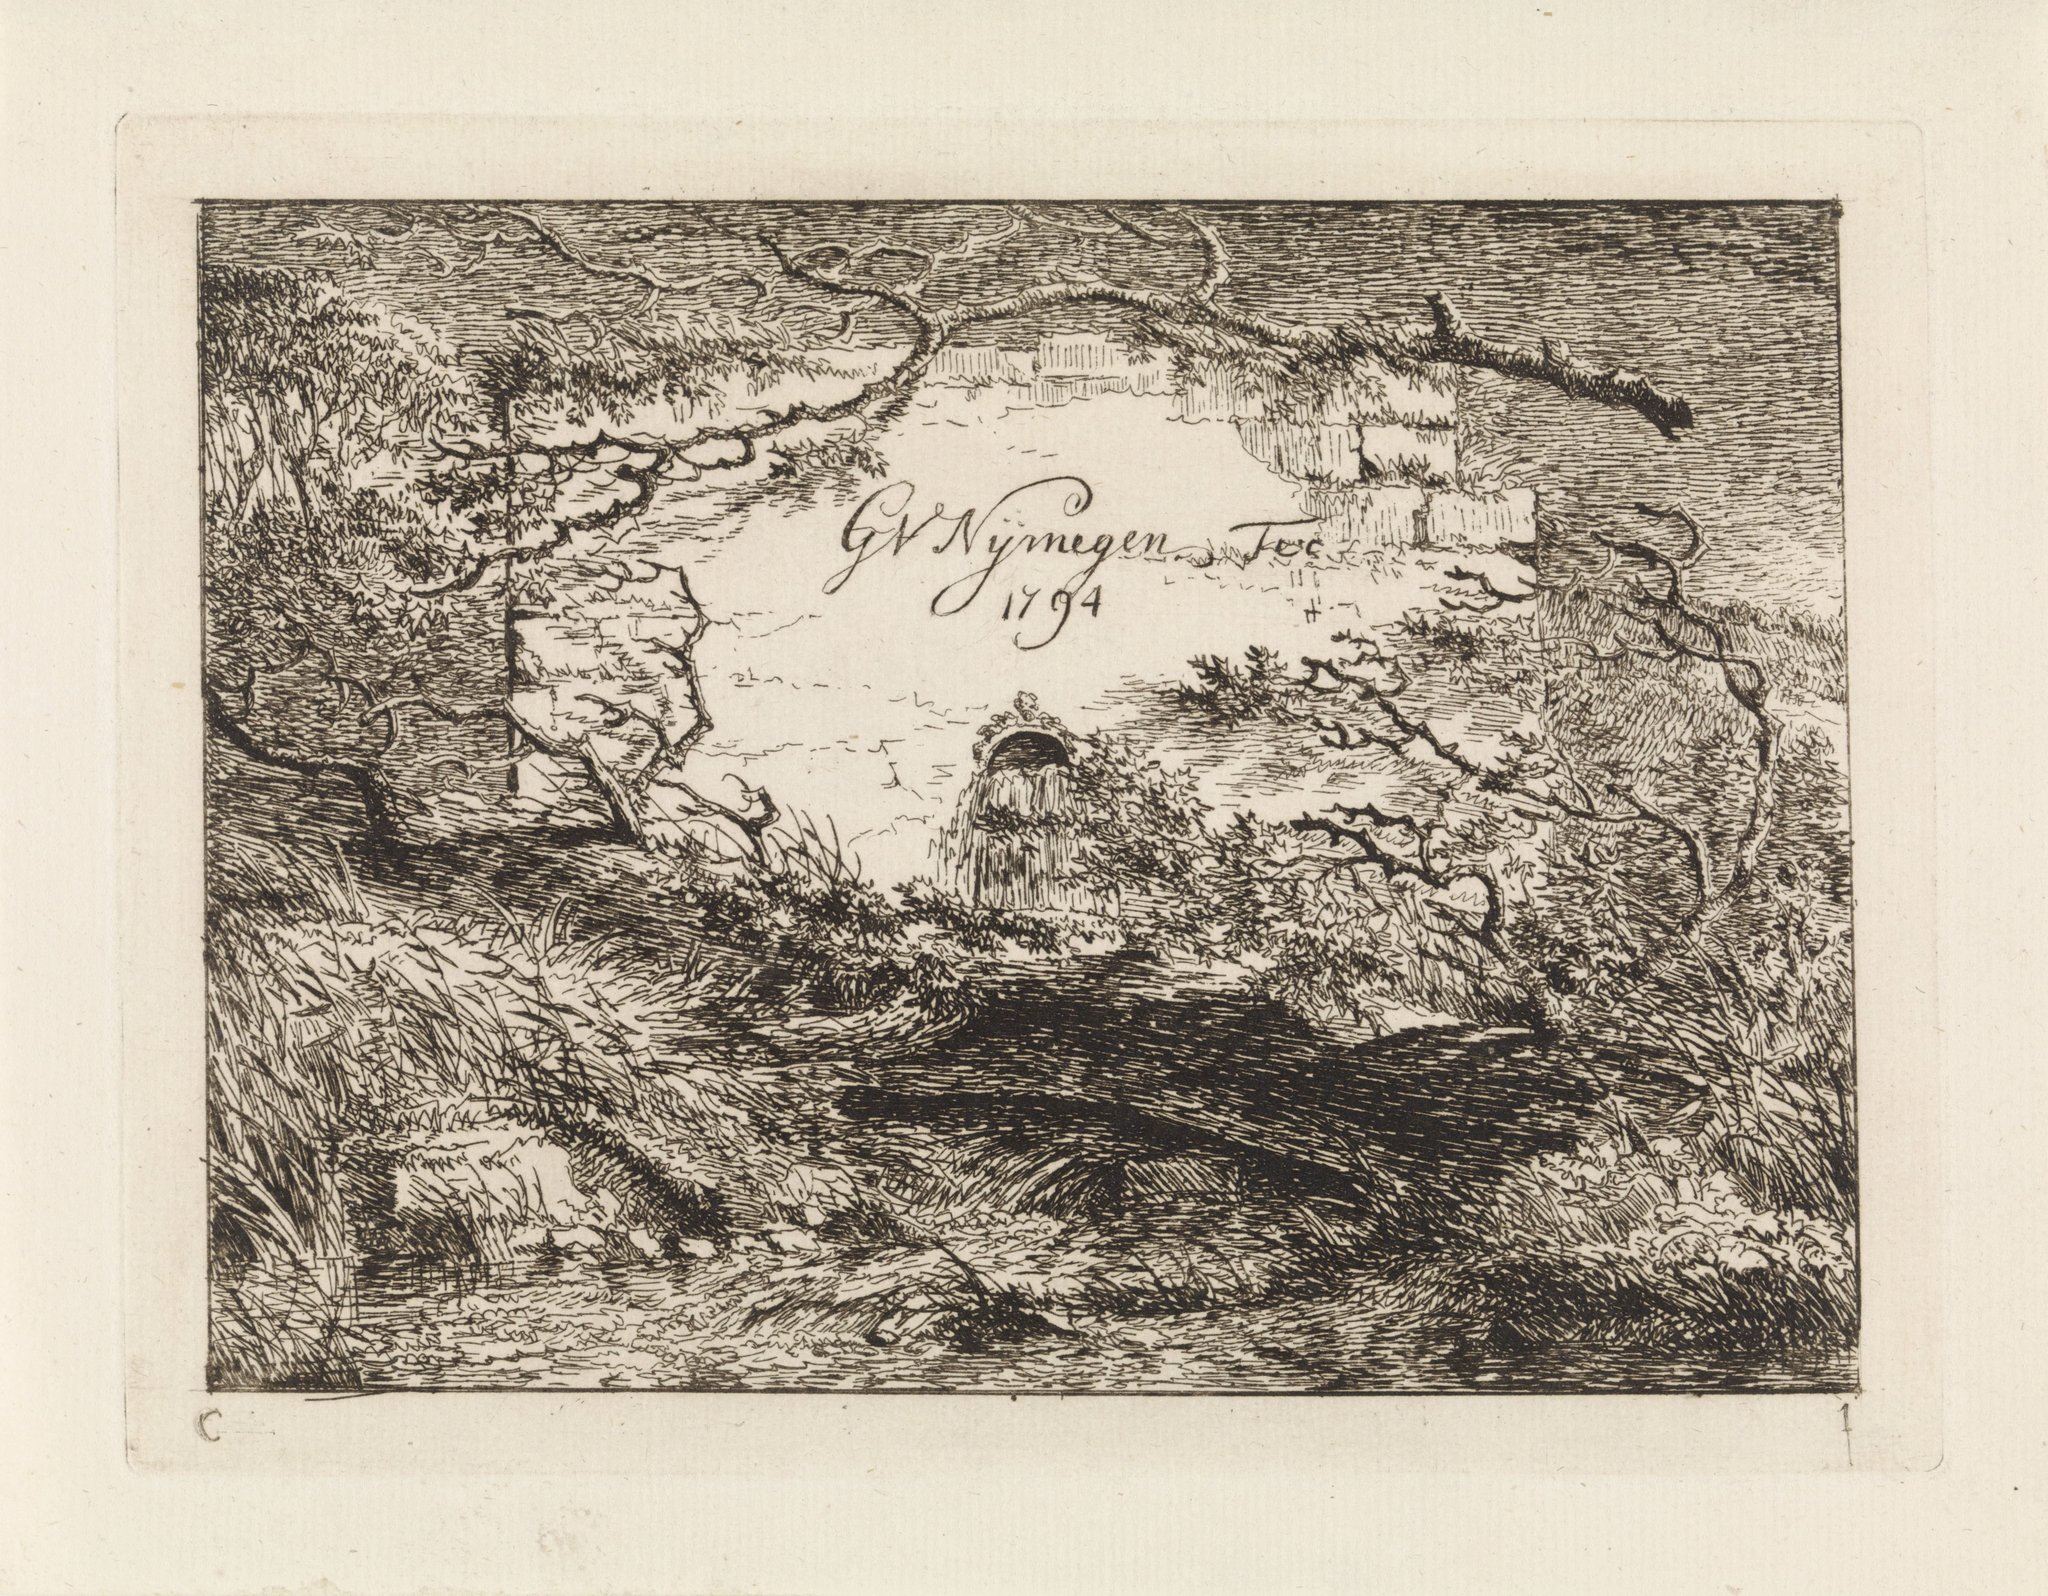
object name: print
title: Muur met watertoevoer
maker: gerard van nijmegen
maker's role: draughtsman, painter, print maker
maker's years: 1735-1808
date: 1794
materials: paper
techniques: etching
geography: rotterdam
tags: fence, wall, paling, brook, utilitarian, public pump or water fountain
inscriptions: collector's mark: Lugt 2228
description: Een verweerde muur met in het midden een gat waaruit water stroomt in een beekje. Aan weerskanten van de muur staan struiken. Linksonder: c.